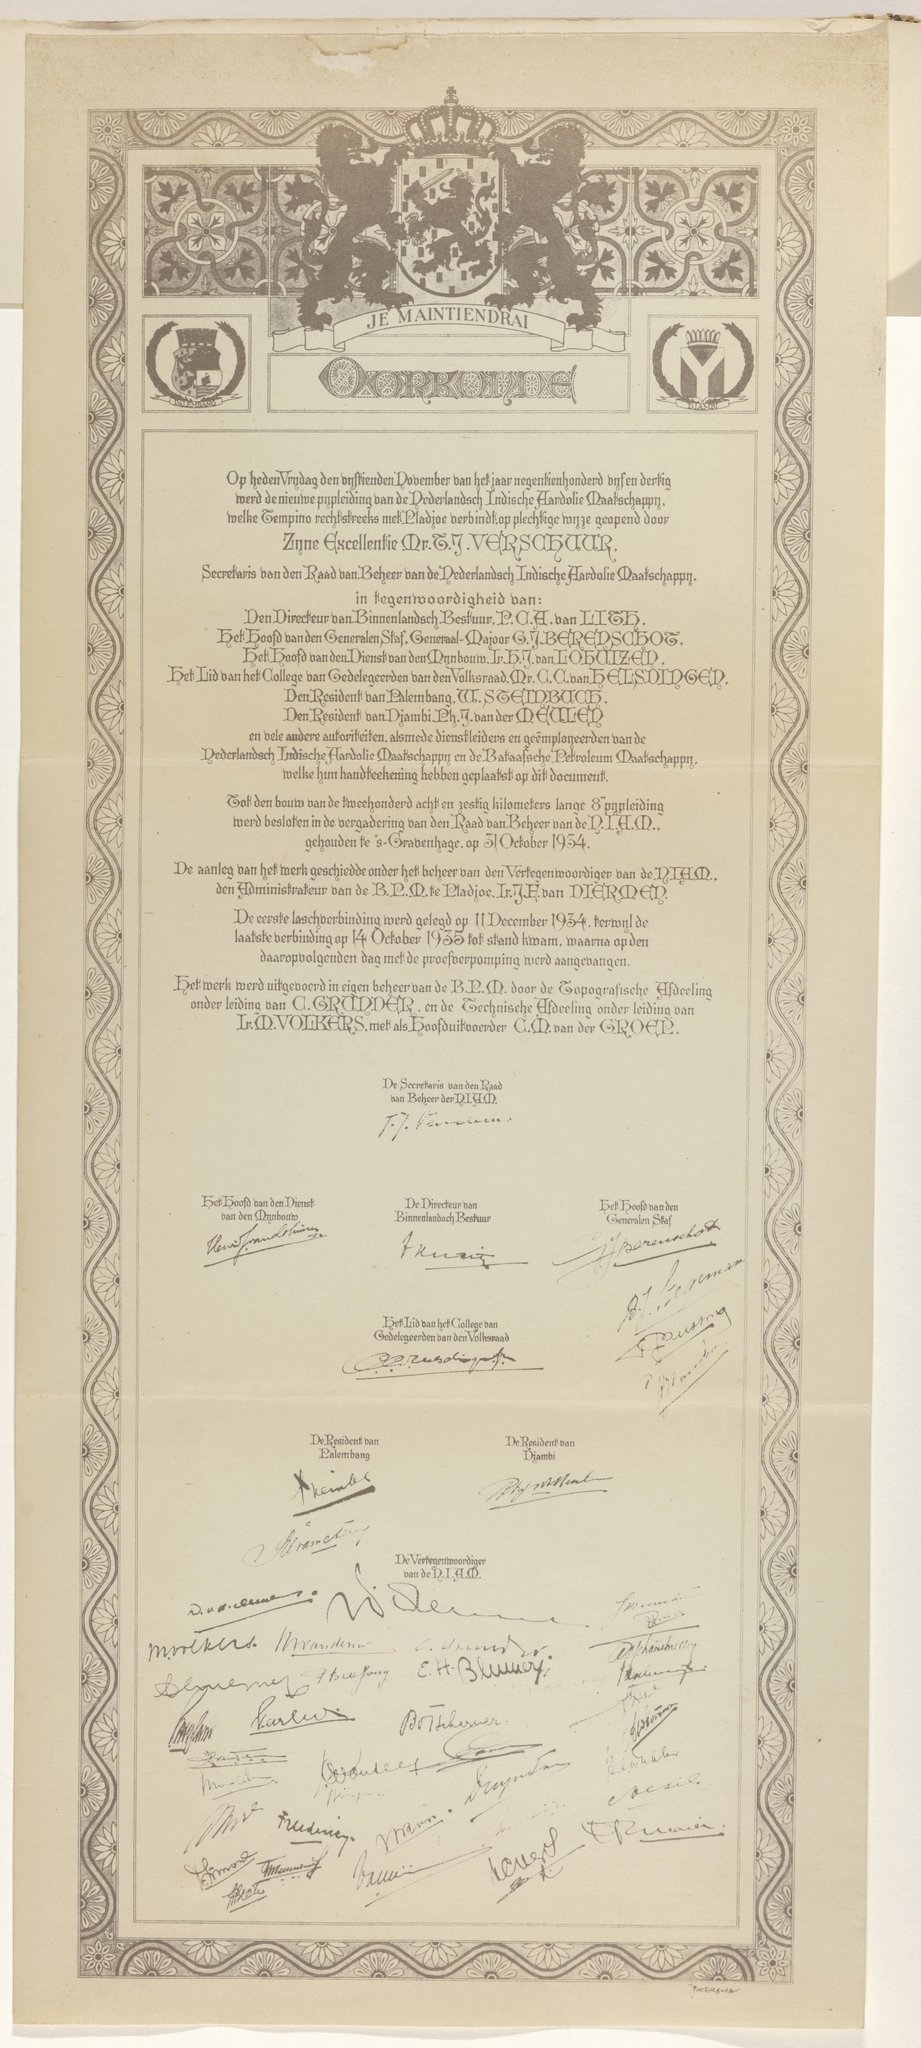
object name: charter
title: Oorkonde ter gelegenheid van de feestelijke ingebruikstelling van de pijpleiding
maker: Anonymous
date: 1935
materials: linen, paper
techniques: printing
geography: sumatra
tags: utrecht, germany, colonial system, pipeline ~transportation of oil, commemoration, jubilee, sumatra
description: Reproductie van de oorkonde uitgereikt bij de feestelijk opening. Gekalligrafeerde oorkonde met handtekeningen van de officiële gasten: secretaris van de Raad van Bestuur van de NIAM T.J. Verschuur, directeur binnenlands bestuur P.C.A. van Lith, hoofd Generale Staf generaal-majoor G.J. Berenschot, hoofd Dienst Mijnbouw ir. H.J. van Lohuizen, lid college van Gedelegeerden van de Volksraad C.C. van Helsdingen, resident van Palembang W. Steinbach, resident van Djambi Ph.J. van der Mealen. Document opgevouwen en ingeplakt in het fotoalbum samengesteld ter gelegenheid van de feestelijke ingebruikstelling van de pijpleiding van Tempino naar Pladjoe op Sumatra door de Nederlandsch-Indische Aardolie Maatschappij (NIAM) op 15 november 1935.